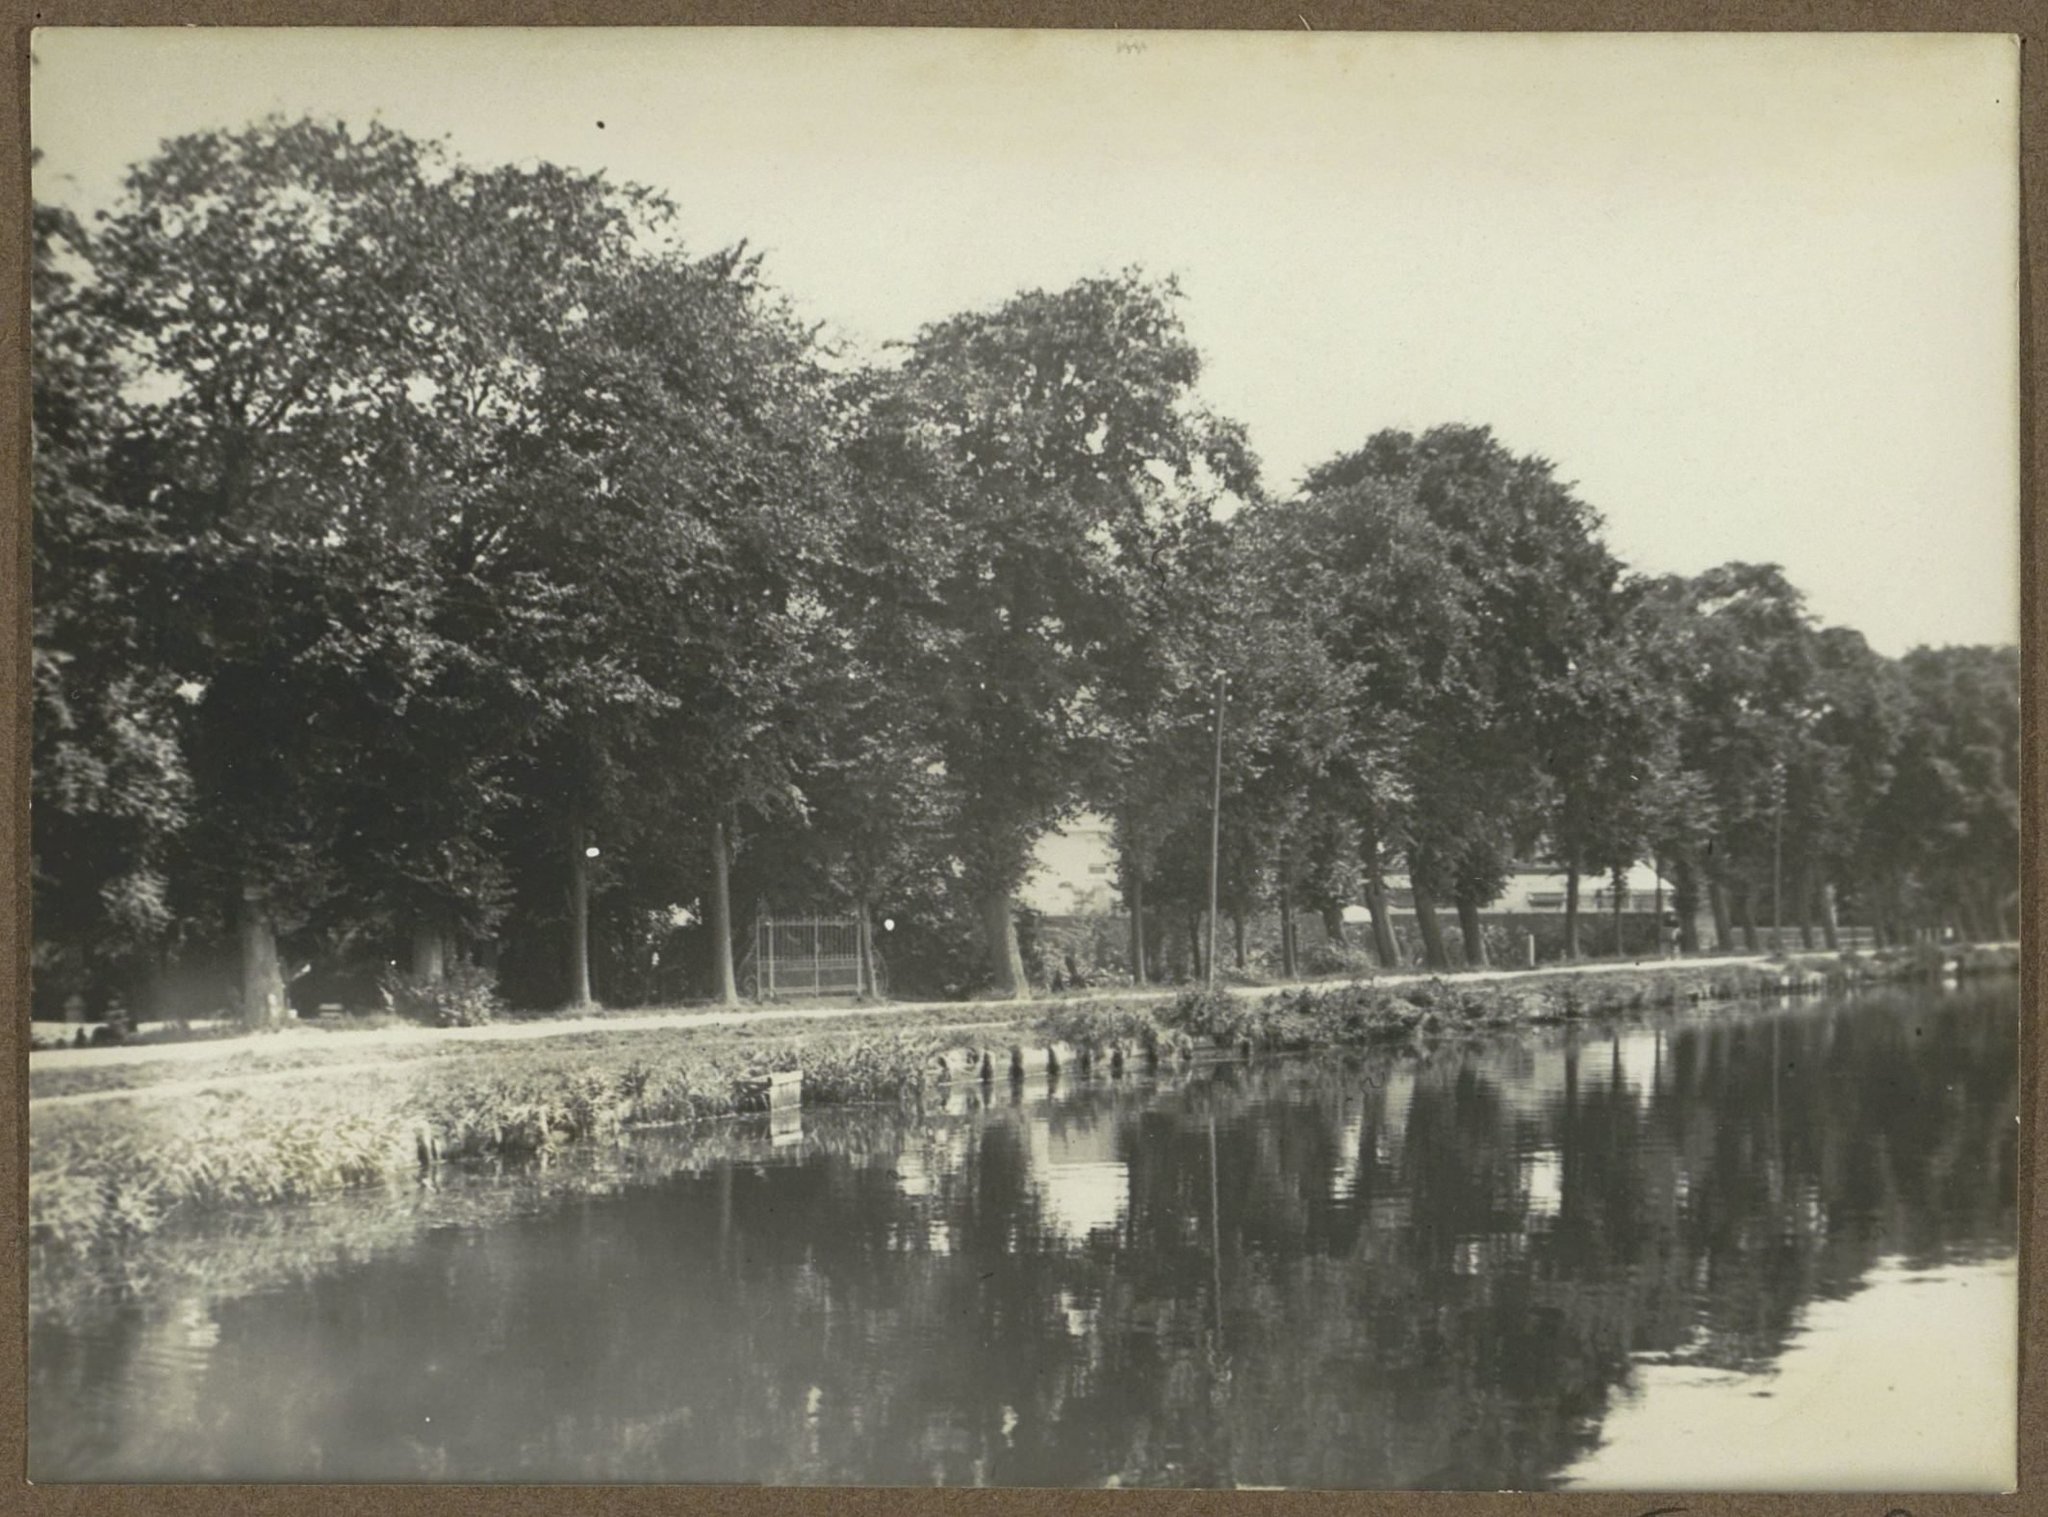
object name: photograph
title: Gezicht op de oever van de Amstel aan de Amsteldijk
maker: Anonymous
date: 1910-1935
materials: paper, photographic support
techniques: gelatin silver print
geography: amsterdam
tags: river, river bank, amsterdam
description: Onderdeel van Album met foto's van Amsterdam en omgeving.